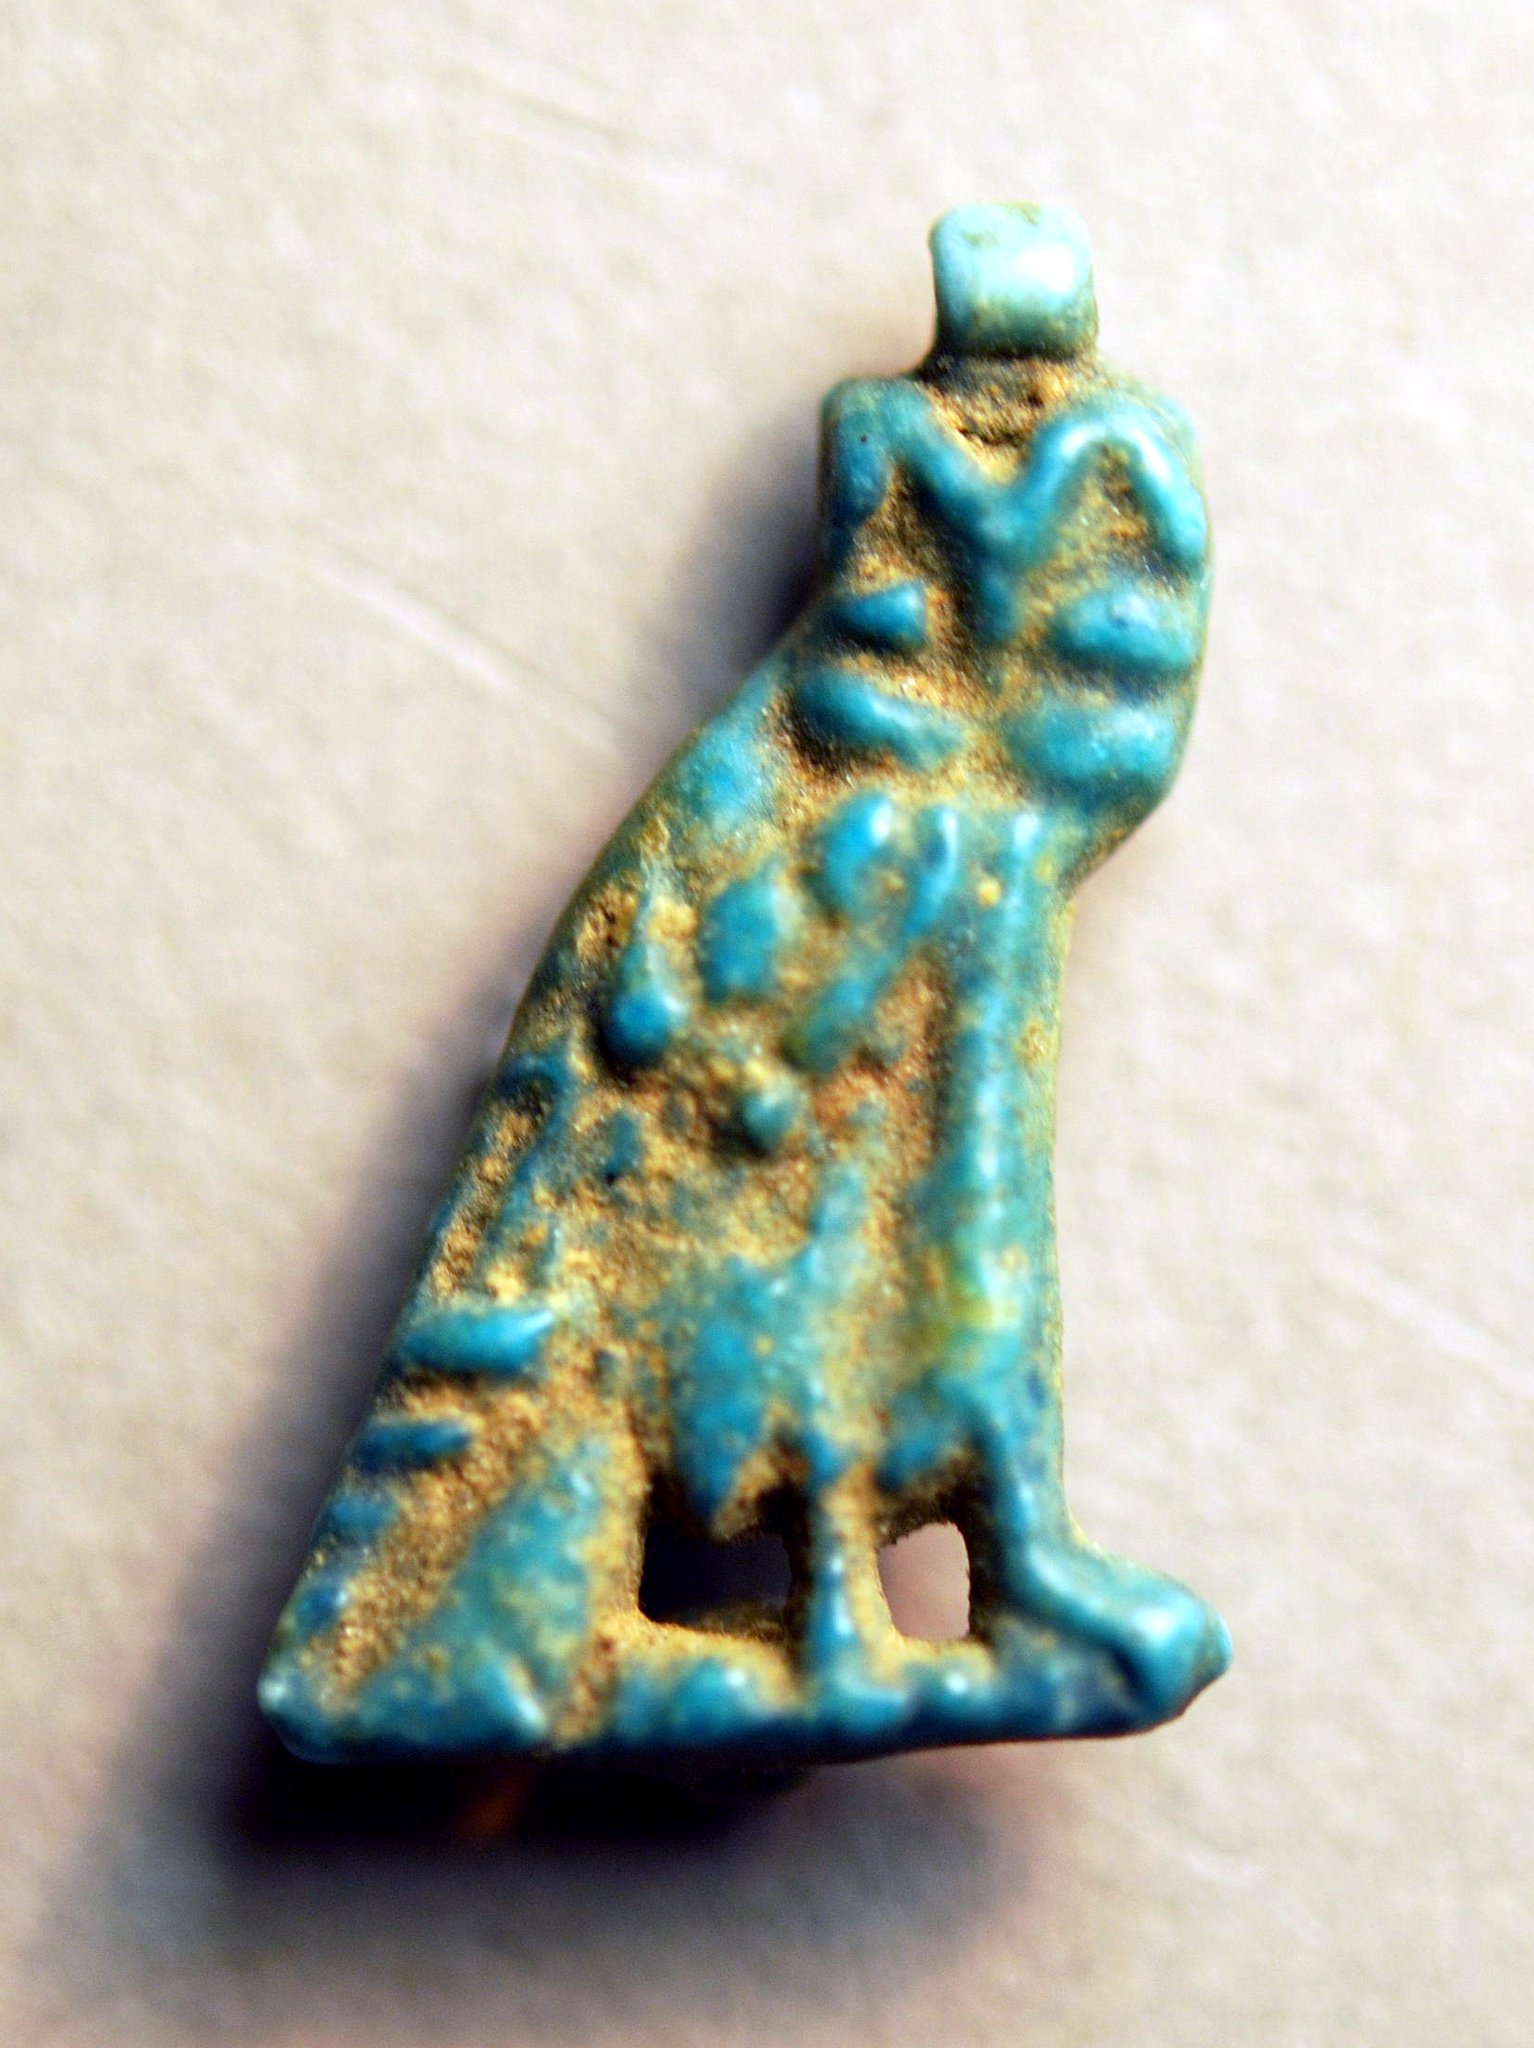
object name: amulet, owl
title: Owl Amulet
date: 1390-1352 BCE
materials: faience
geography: egypt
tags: owls